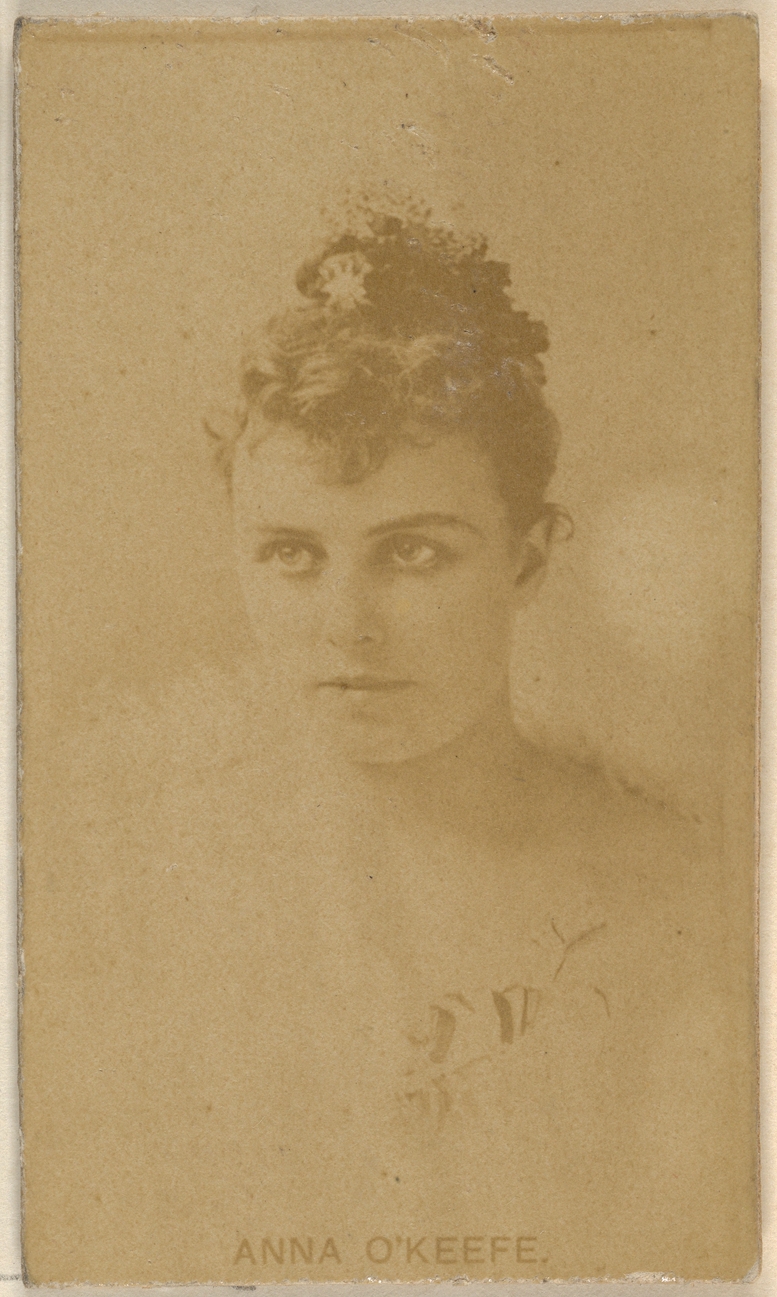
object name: photograph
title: Anna O'Keefe, from the Actors and Actresses series (N45, Type 8) for Virginia Brights Cigarettes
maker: allen & ginter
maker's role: publisher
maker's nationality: american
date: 1888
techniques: albumen silver print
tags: portraits,women,actresses